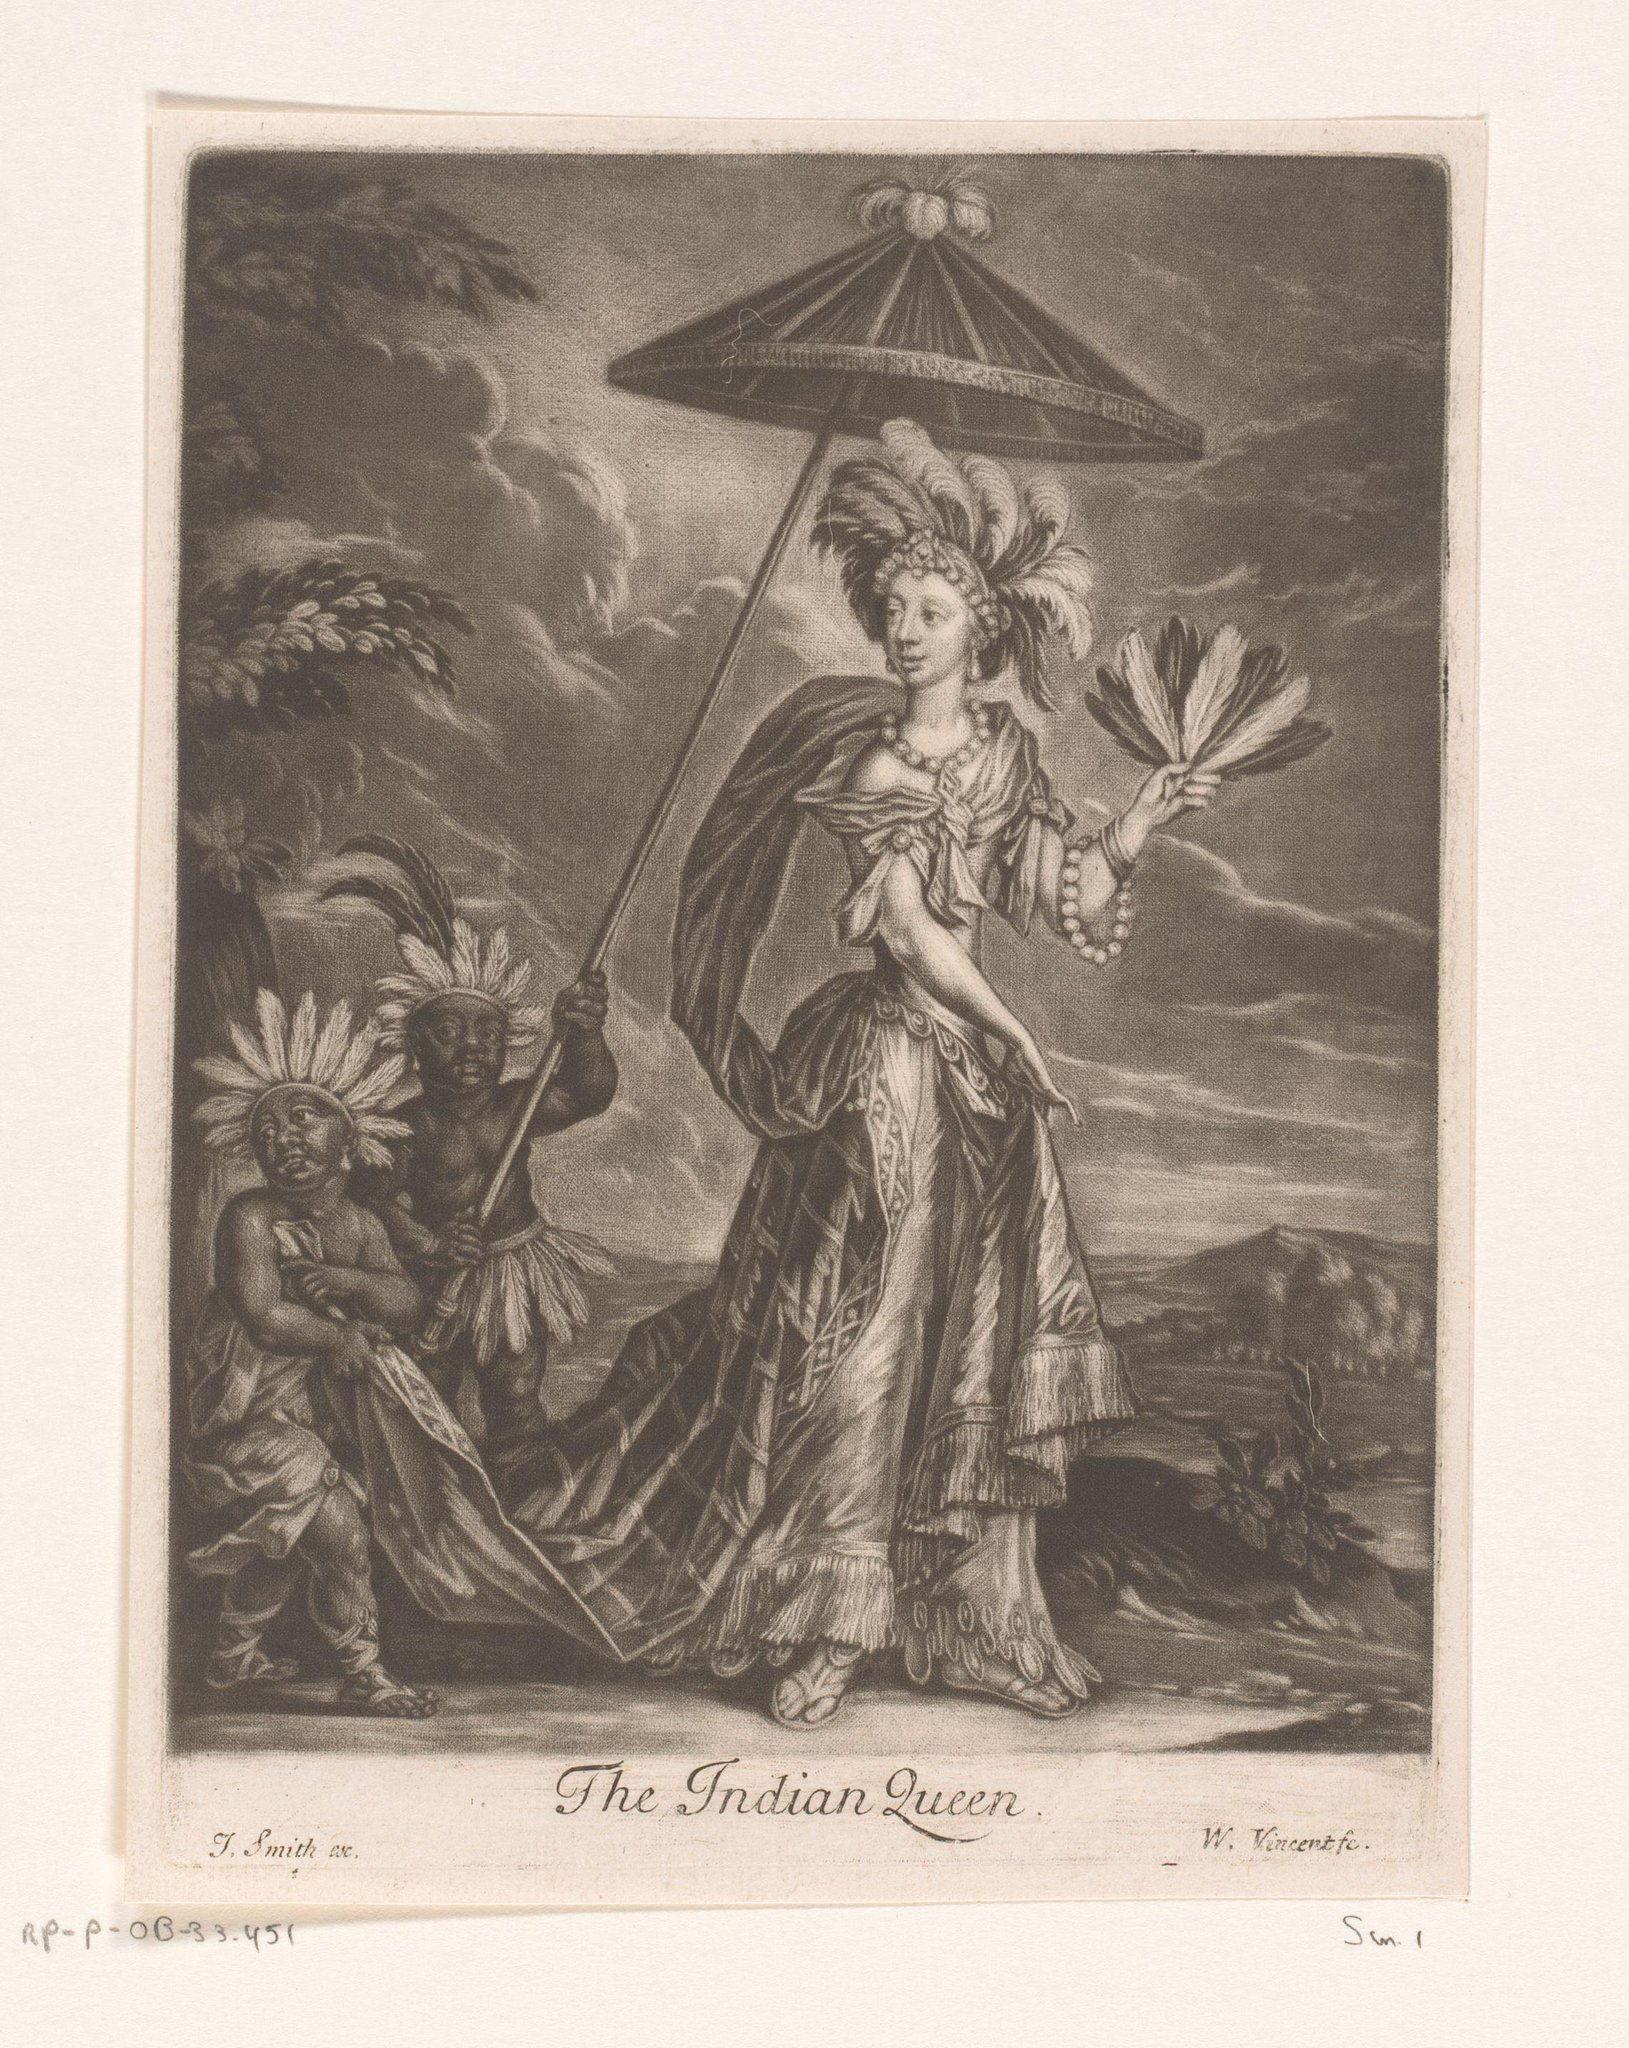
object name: print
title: The Indian Queen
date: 1689-1695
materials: paper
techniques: mezzotint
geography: london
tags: historical persons - bb - woman, indigenous peoples of north america, portrait of actor, actress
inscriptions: collector's mark: Lugt 240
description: Bracegirdle als de koningin van oorspronkelijke bewoners van Amerika, uit Aphra Behns 'The Widow Ranter, or, the History of Bacon in Virginia'.